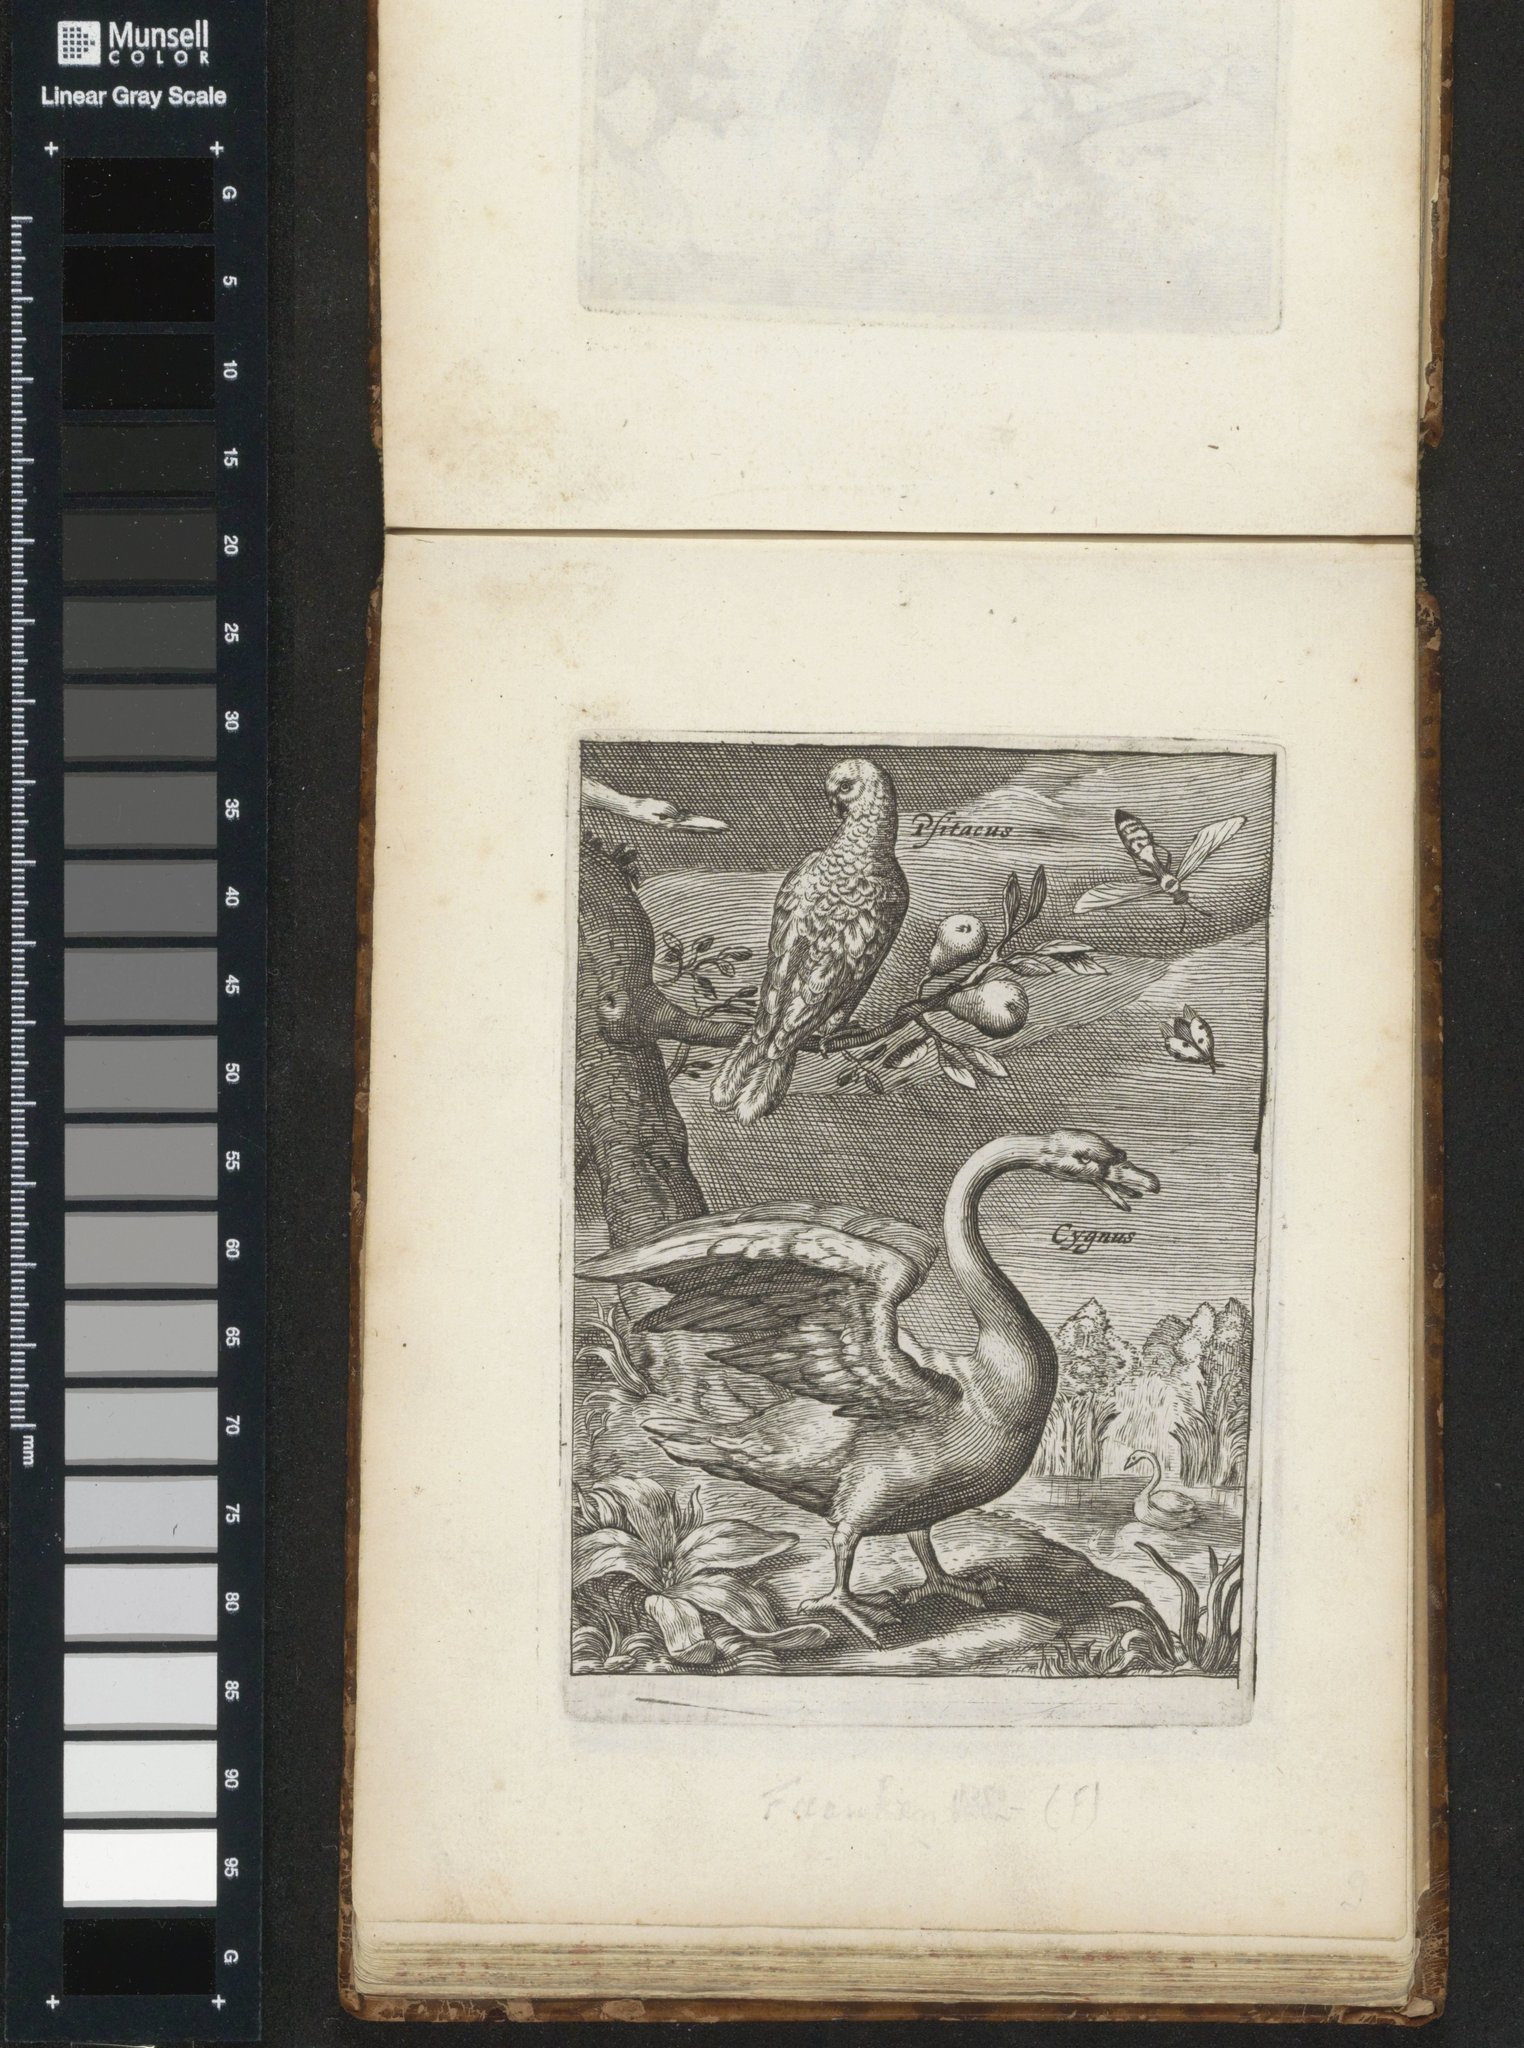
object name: print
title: Avium Vivae Icones (...)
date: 1635-1660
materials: paper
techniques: engraving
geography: utrecht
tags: water-birds: swan, ornamental birds: parrot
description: Landschap met op de voorgrond een zwaan. Op een tak een papegaai. In de lucht insecten. Deze prent maakt deel uit van een album.